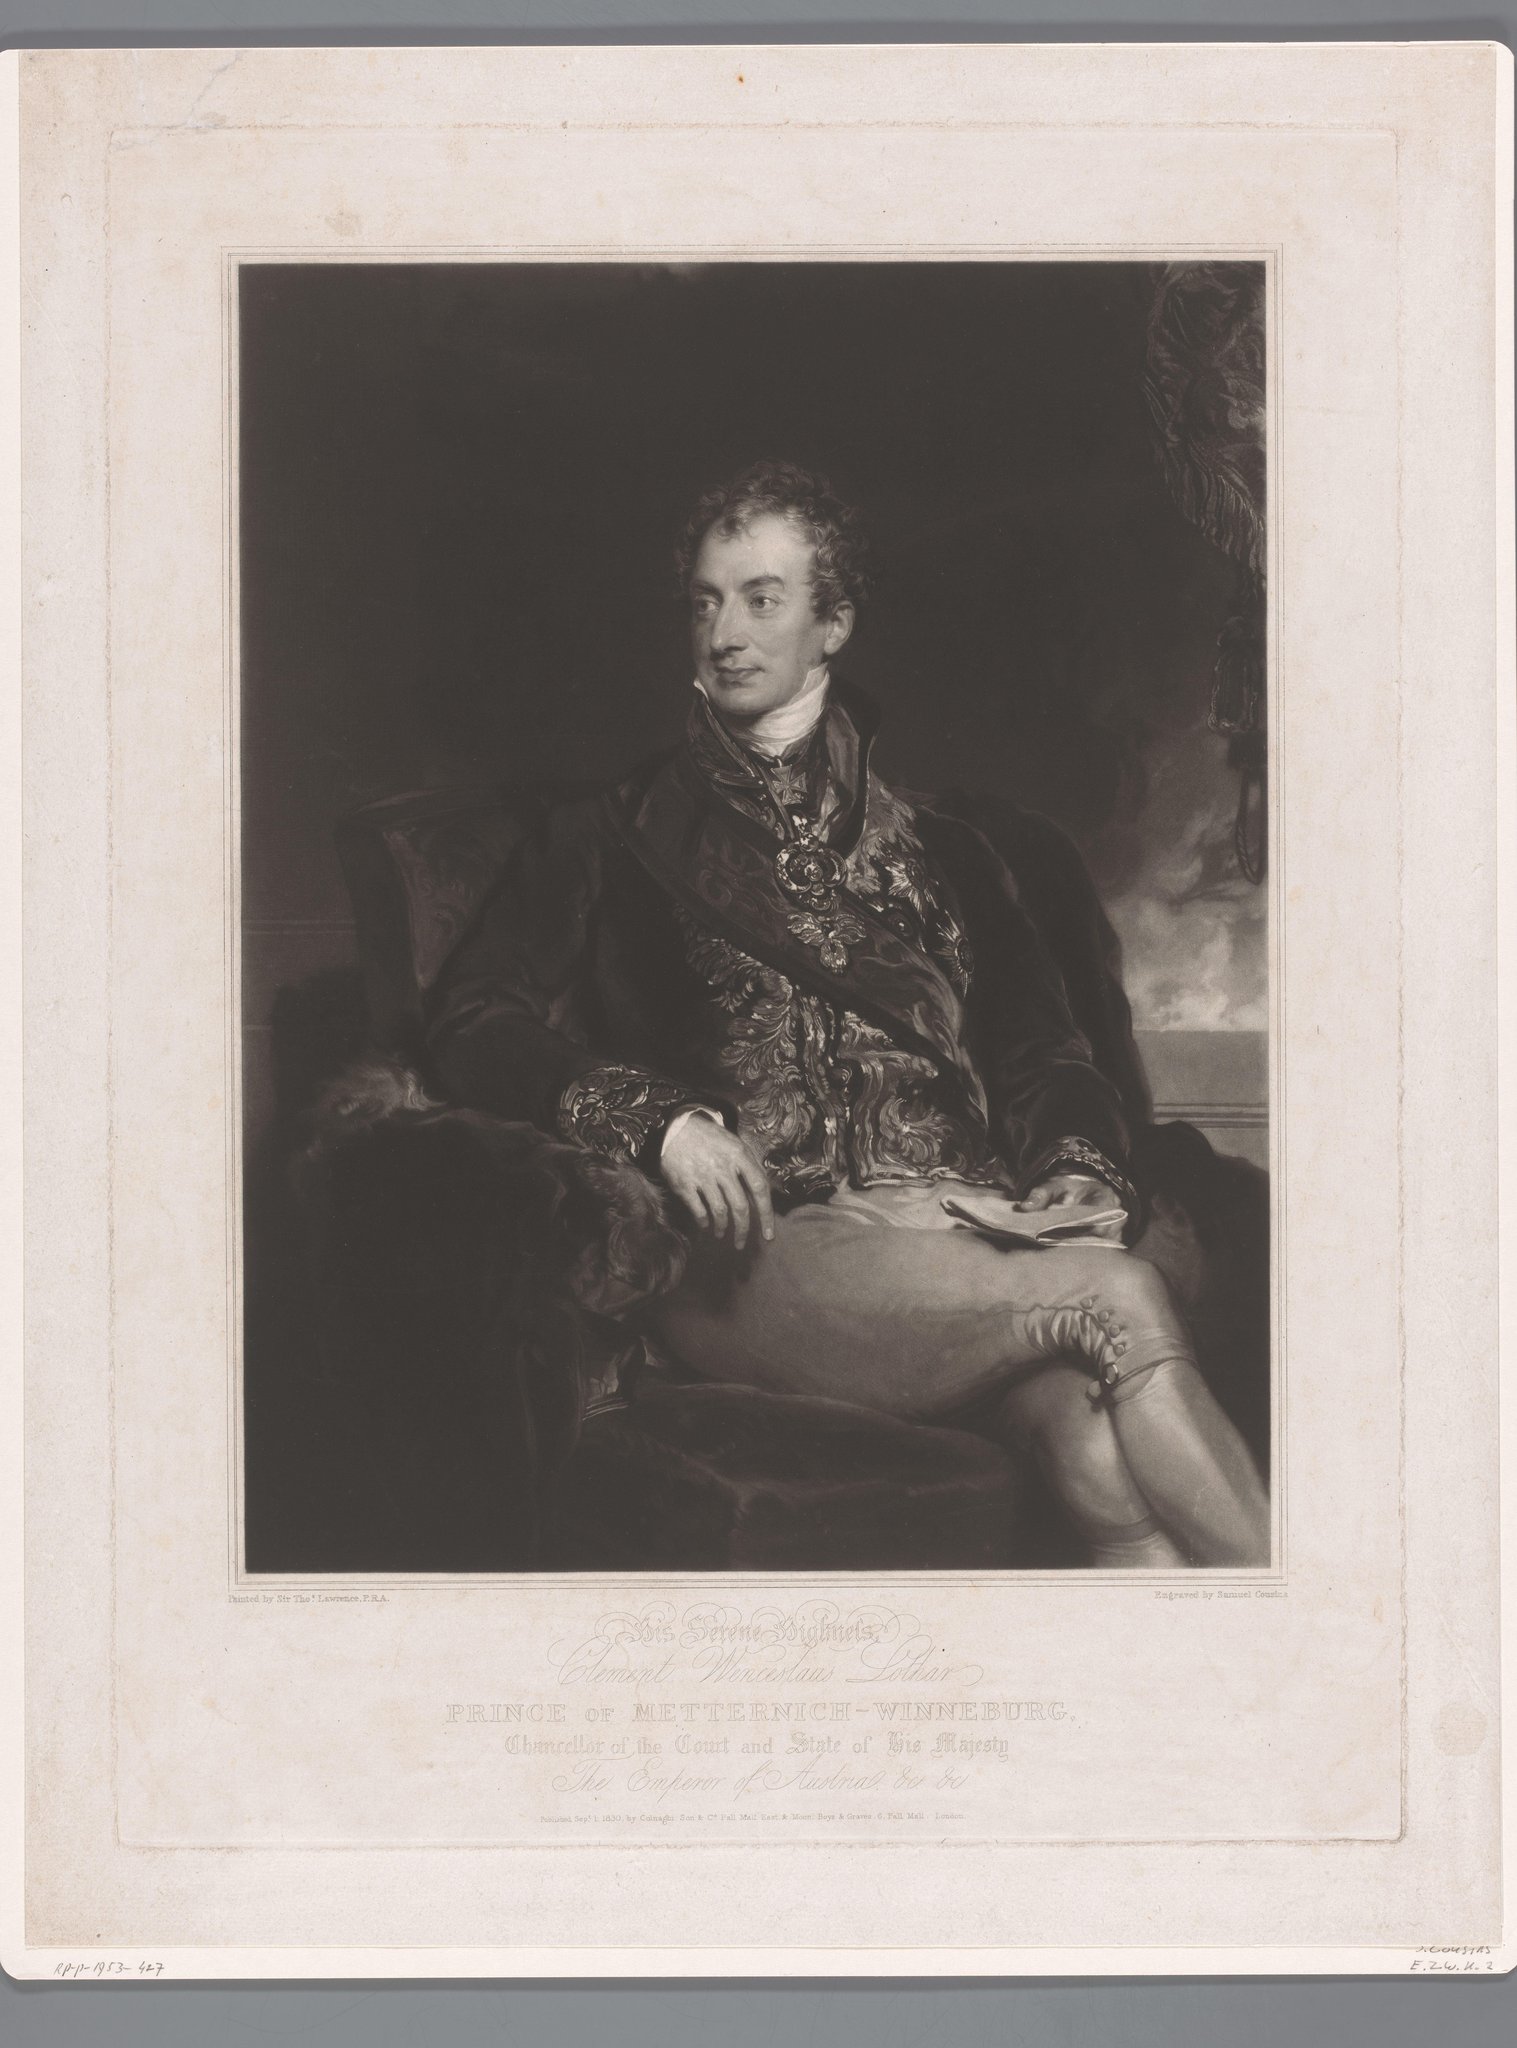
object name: print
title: Portrait of Klemens Wenzel Lothar von Metternich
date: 1830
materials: paper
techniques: mezzotint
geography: london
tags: vienna, historical persons, diplomacy, diplomat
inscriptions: collector's mark: Lugt 2760, collector's mark: Lugt 2228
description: Metternich was one of the greatest diplomats of his time. In 1814-1815 he led the Congress of Vienna, meant to establish a new balance of power in Europe after the defeat of Napoleon Bonaparte. Metternich sat to Lawrence in London in 1814, and in Aix-en-Provence and Vienna in 1818. These sessions may have been for the same portrait: Lawrence was notorious for the length of time he sometimes took to complete a painting.